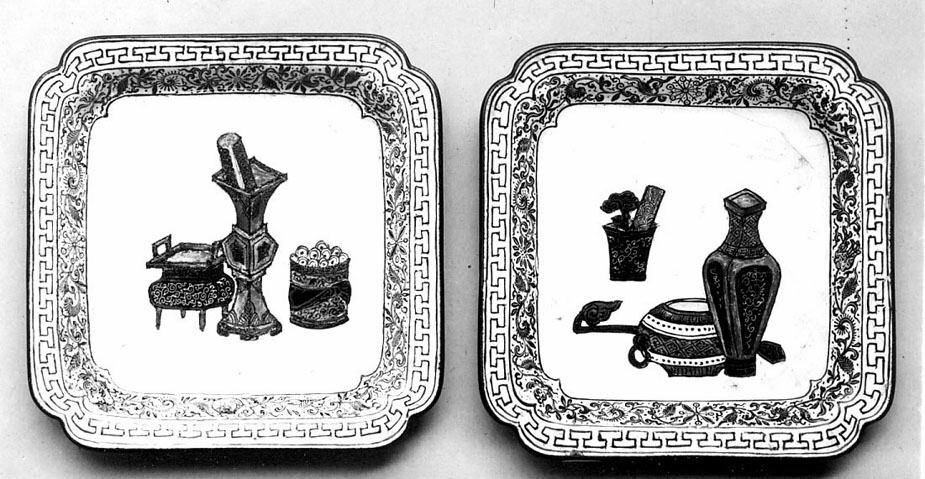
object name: dish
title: Square Dish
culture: chinese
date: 1736-1795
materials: enamel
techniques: painting